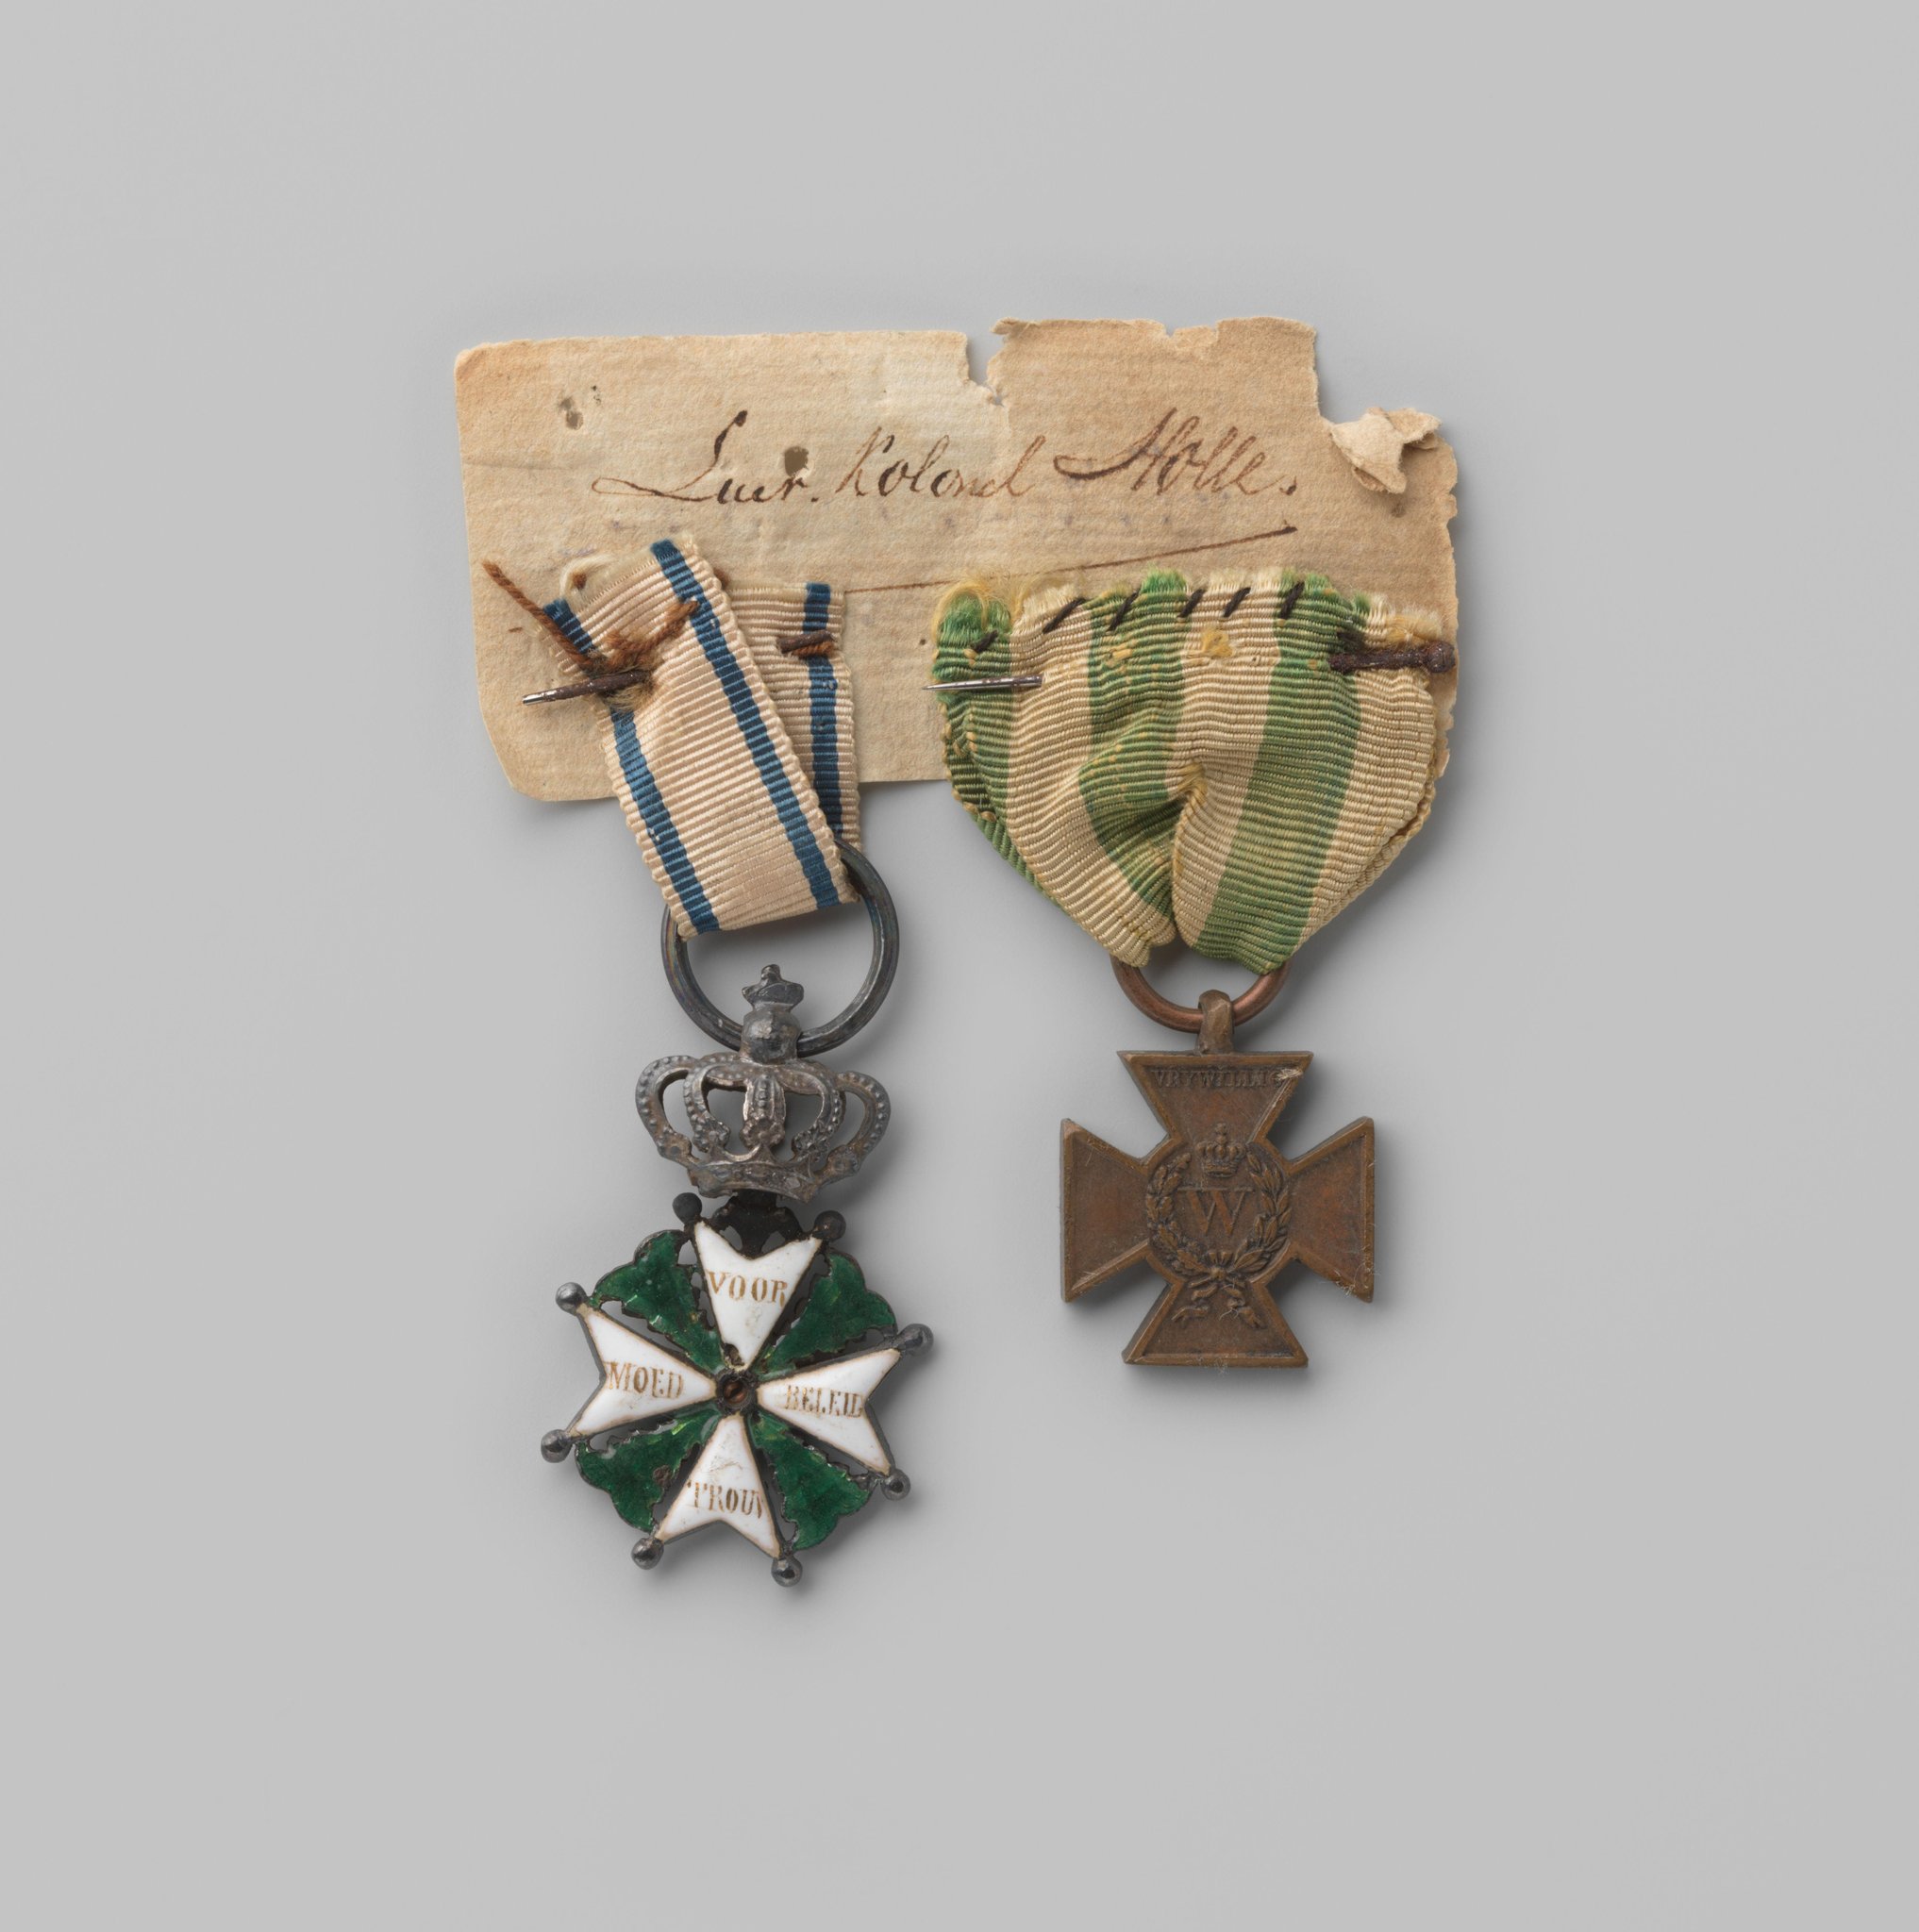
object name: onderscheidingsteken, onderscheiding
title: Miniatuur van Militaire Willems-Orde Ridder 4e klasse en een miniatuur van Metalen Kruis Vrijwilligers 1830-1831, verleend aan Mr. J.H. Holle, luitenant-kolonel bij de mobiele Zuid-Hollandsche schutterij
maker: Anonymous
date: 1832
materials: bronze, iron, textile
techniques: forging, striking, weave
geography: netherlands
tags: metalen kruis, militaire willemsorde, luitenant-kolonel, johannes hermanus holle, belgische revolutie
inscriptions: : ‘VOOR/ MOED/ BELEID/ TROUW’, : ‘TROUW AAN/ KONING/ EN/ VADERLAND’, : ‘DECEMBER 1832’, : ‘Gekroonde W’, : ‘1830-1831’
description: Miniatuur van een Militaire Willems-Orde Ridder 4e klasse, een miniatuur van een Metalen Kruis voor Vrijwilligers 1830-1831. De Militaire Willems-Orde Ridder 4e klasse is een miniatuur met daarboven een ijzeren kroon, wit geëmailleerde armen met in iedere arm een woord dat tezamen vormt VOOR MOED BELEID. Tussen de armen groen geëmailleerde bladertakken. In het midden ontbreekt de vuurslag. De onderscheiding hangt aan een oranje lint met twee dunne Nassau-blauwe strepen. Naast deze onderscheiding een miniatuur van een Metalen Kruis voor Vrijwilligers 1830-1831 bestaande uit vier armen met daarop de tekst TROUW AAN KONING EN VADERLAND. Het kruis hangt aan een lint welke bestaat uit oranje en groene strepen.